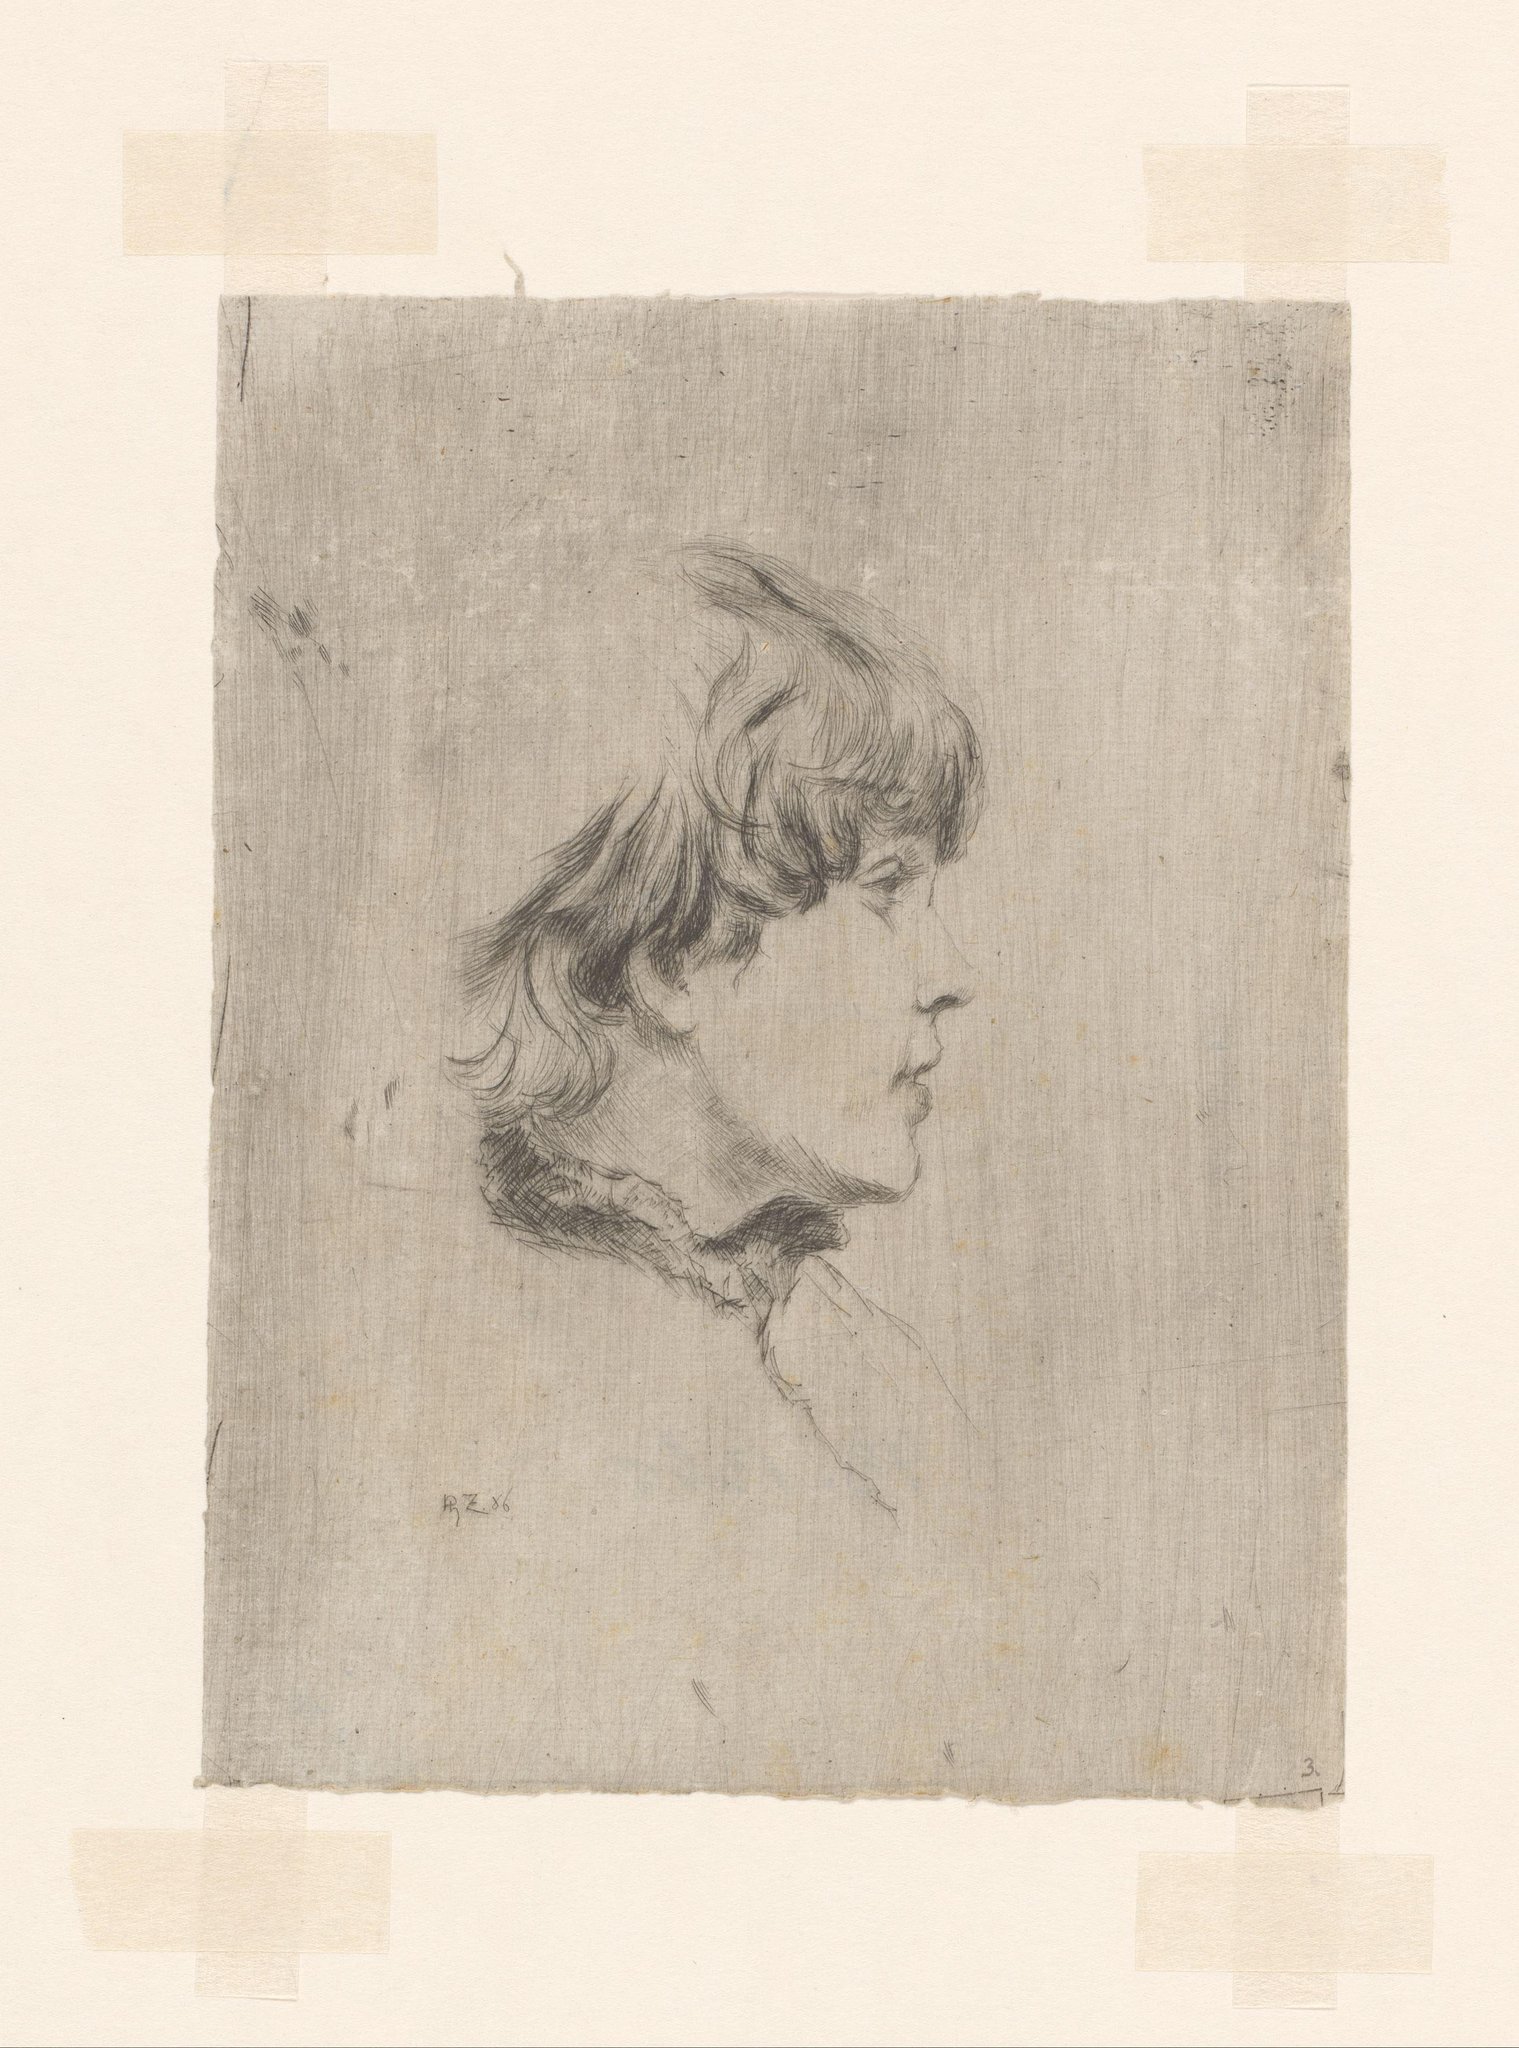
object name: print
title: Hoofd van een meisje, en profil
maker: philip zilcken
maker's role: draughtsman, painter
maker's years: 1857-1930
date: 1886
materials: paper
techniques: drypoint, etching, intaglio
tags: girl (child between toddler and youth)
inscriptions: date